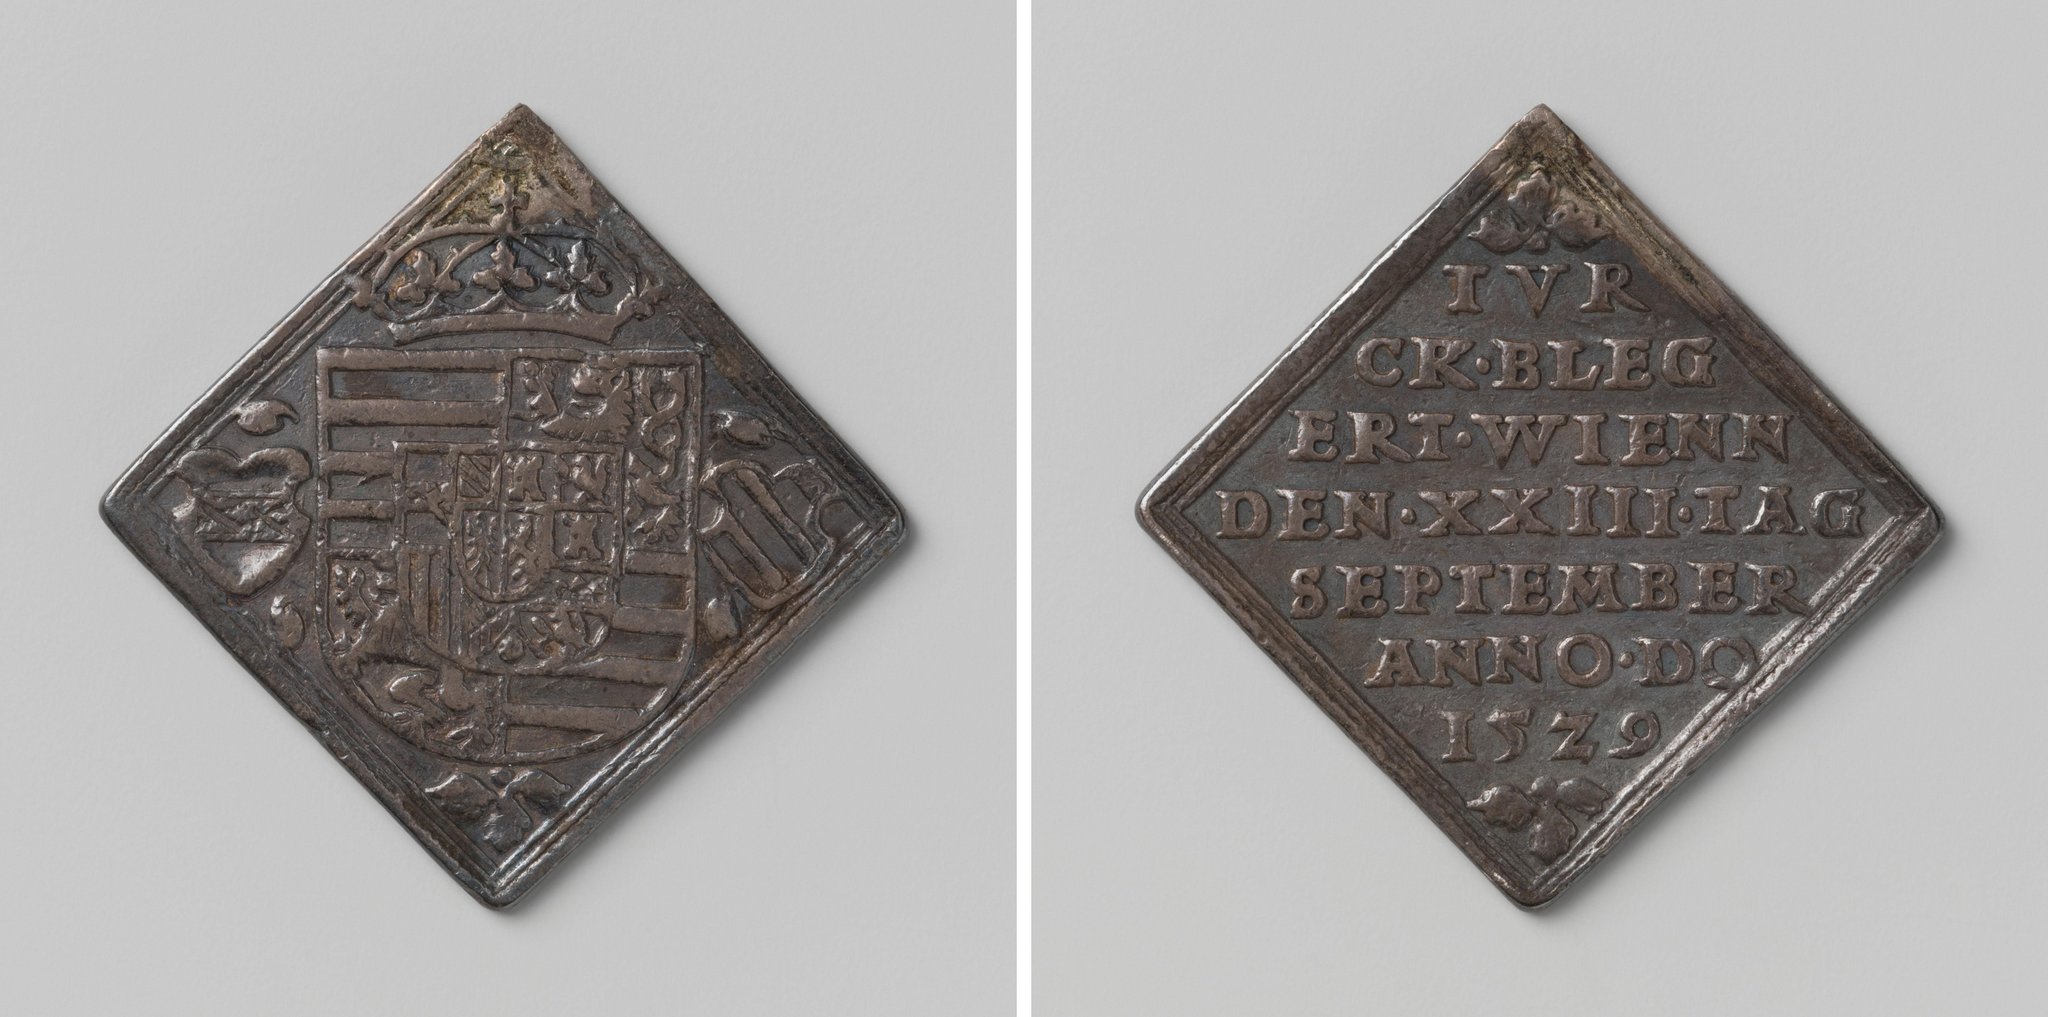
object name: coin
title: Herinneringspenning over het beleg van Wenen door de Turken, in de vorm van een noodmunt van een kwart taler.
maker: Anonymous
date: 1529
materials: silver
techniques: striking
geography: vienna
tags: vienna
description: ruitvormige noodmunt. Voorzijde: gekroond wapenschild; links en rechts: wapenschild. Keerzijde: opschrift onder en boven bloemknop